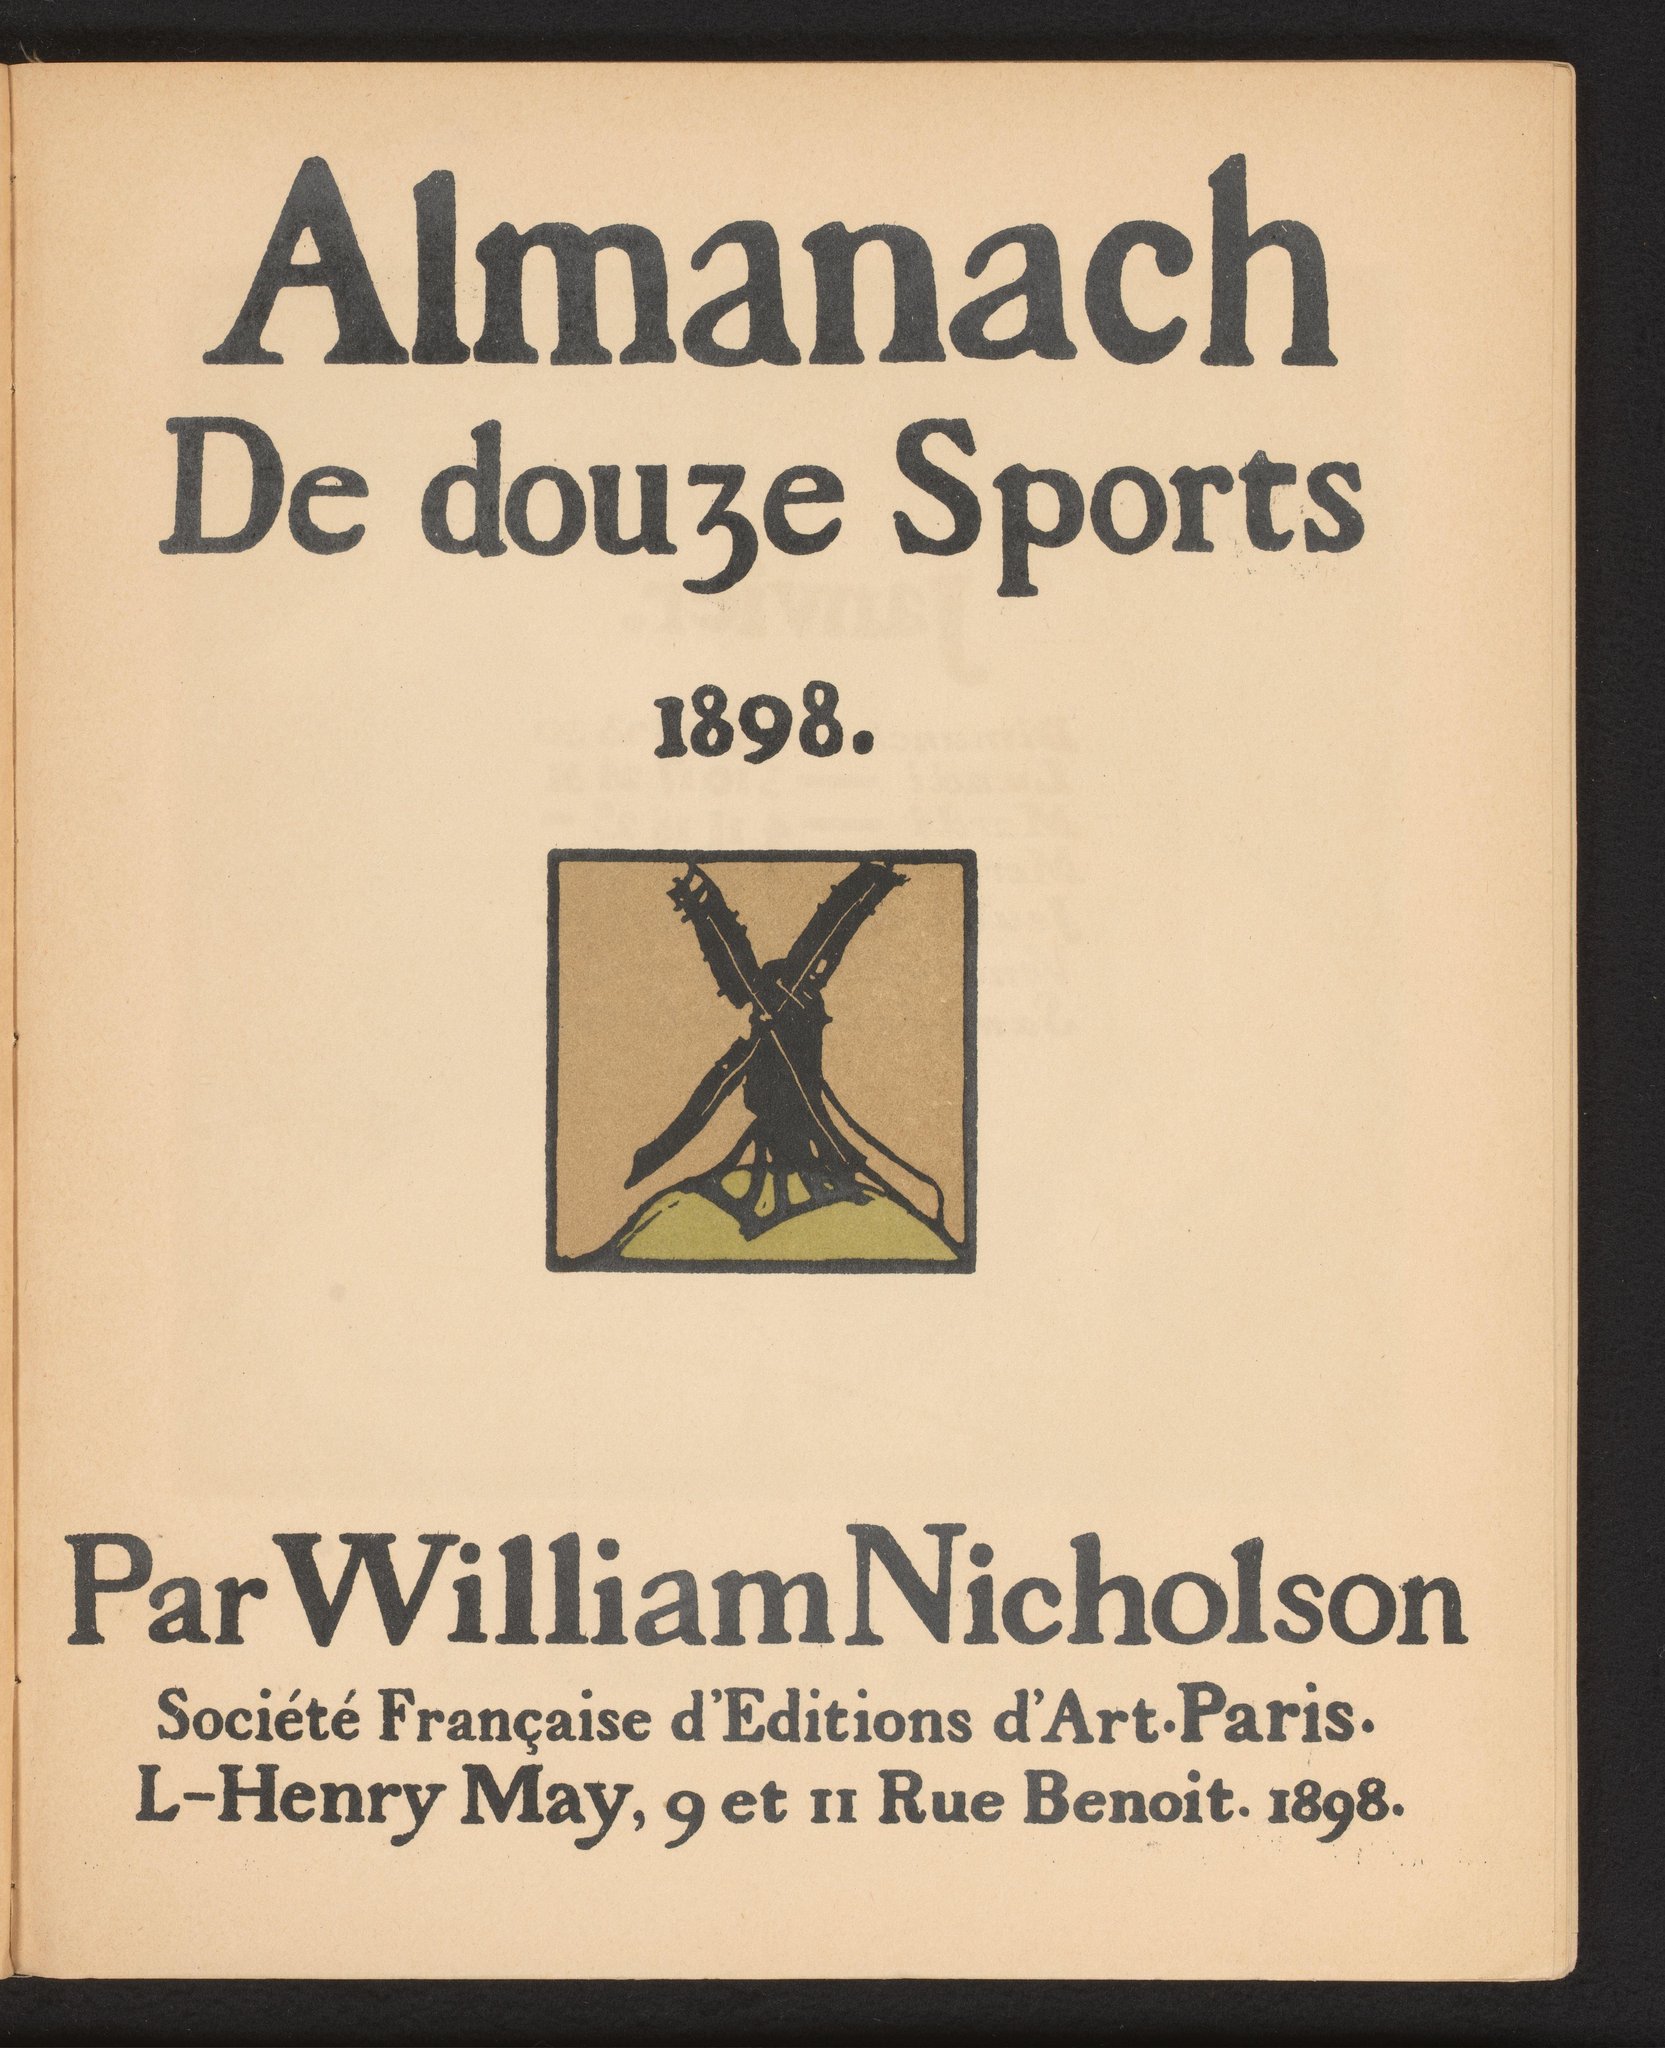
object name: page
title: Molen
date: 1898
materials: paper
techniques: lithograph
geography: paris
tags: windmill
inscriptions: : ‘Janvier/ Dimanche - 29 16 23 30/ Lundi - 3 10 17 24 (...)’